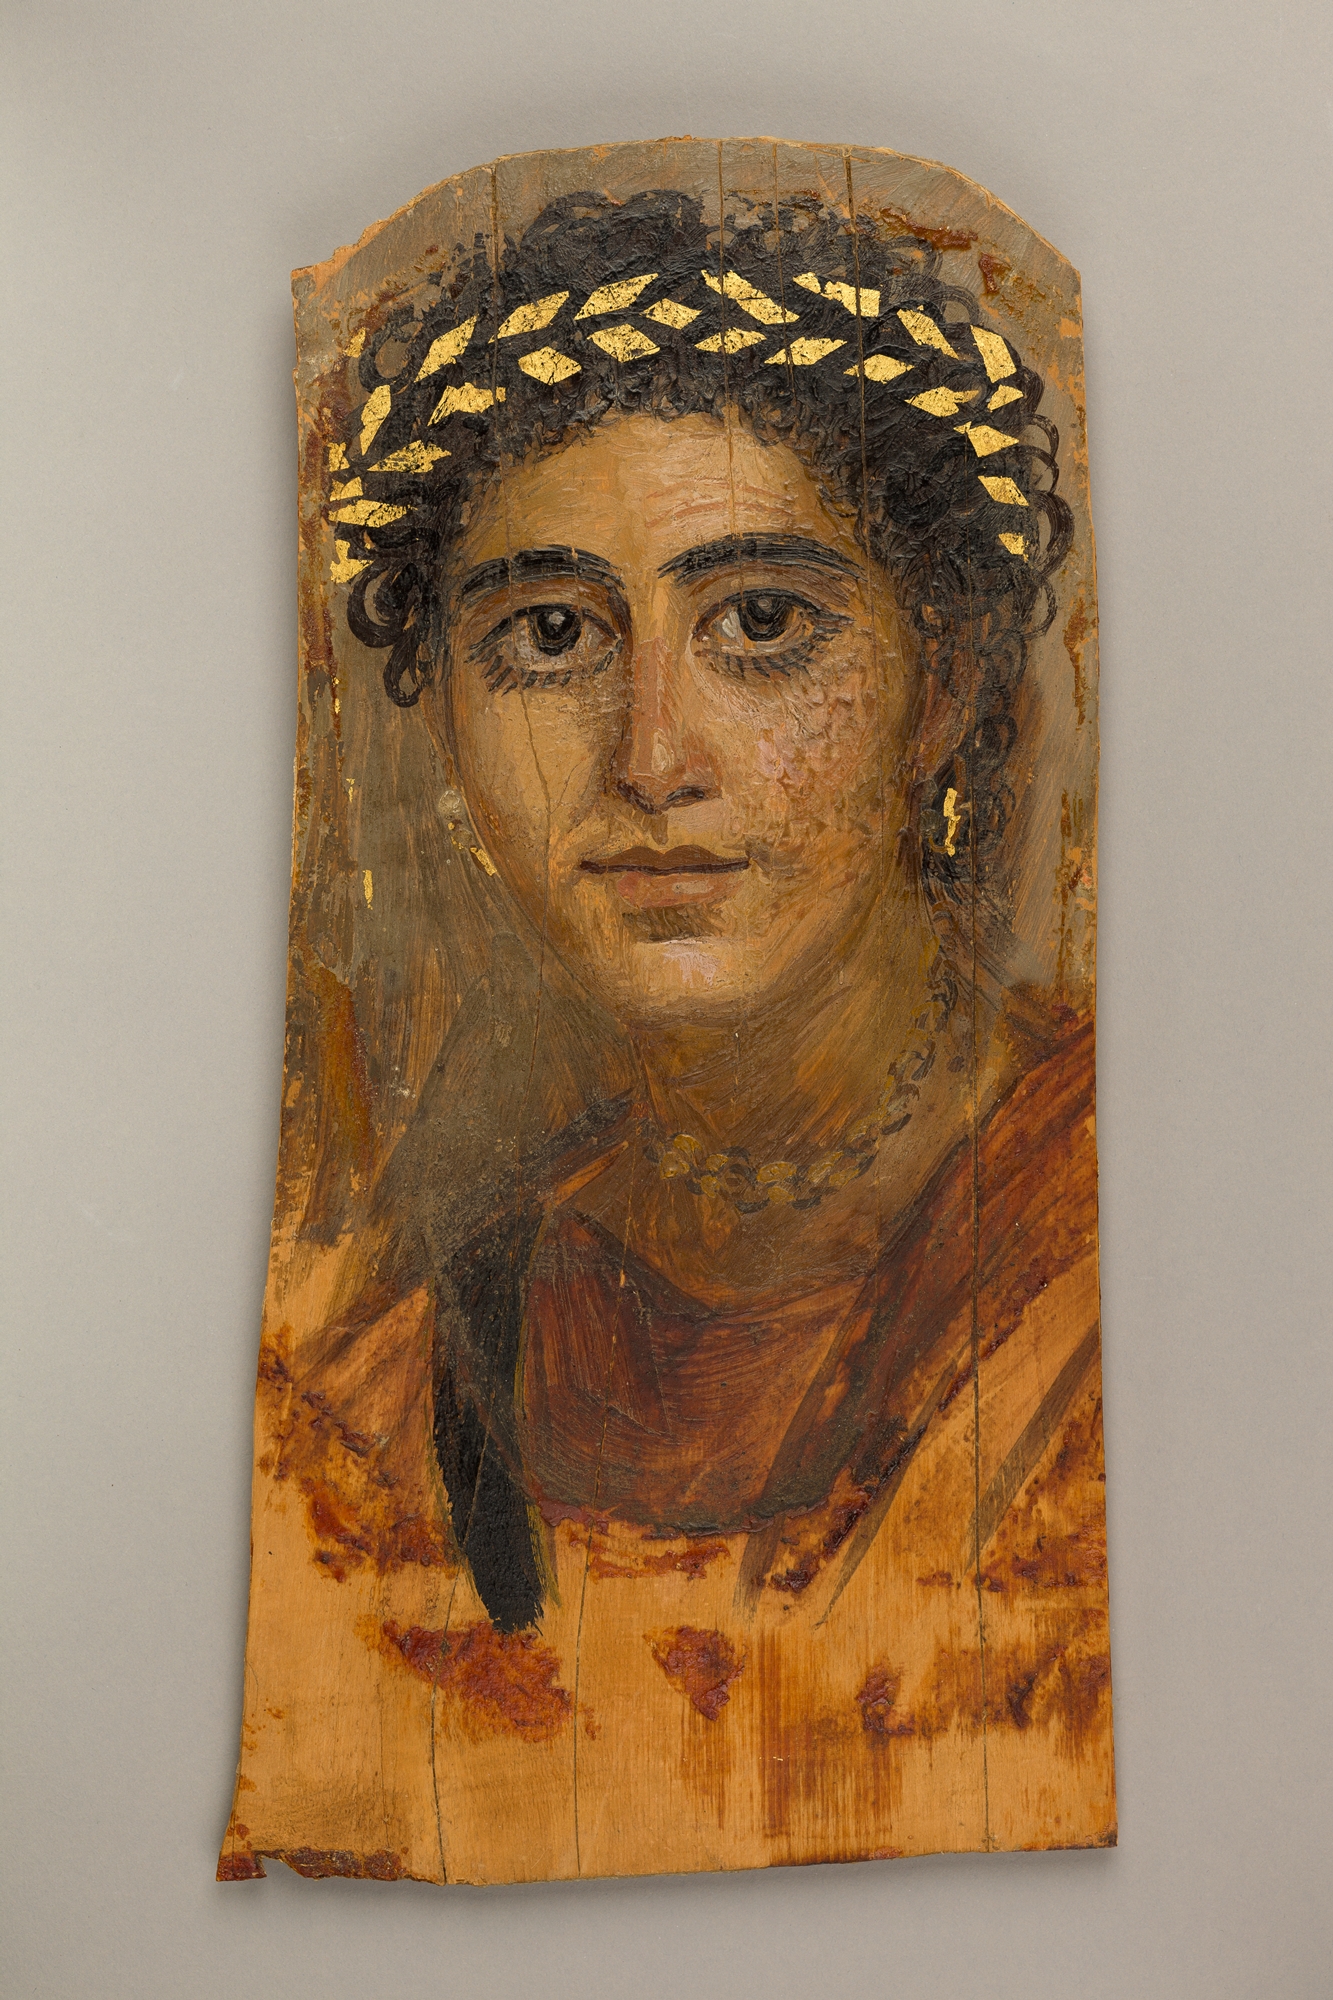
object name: panel painting, young woman in red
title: Portrait of a young woman in red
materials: gold leaf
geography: egypt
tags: portraits,women